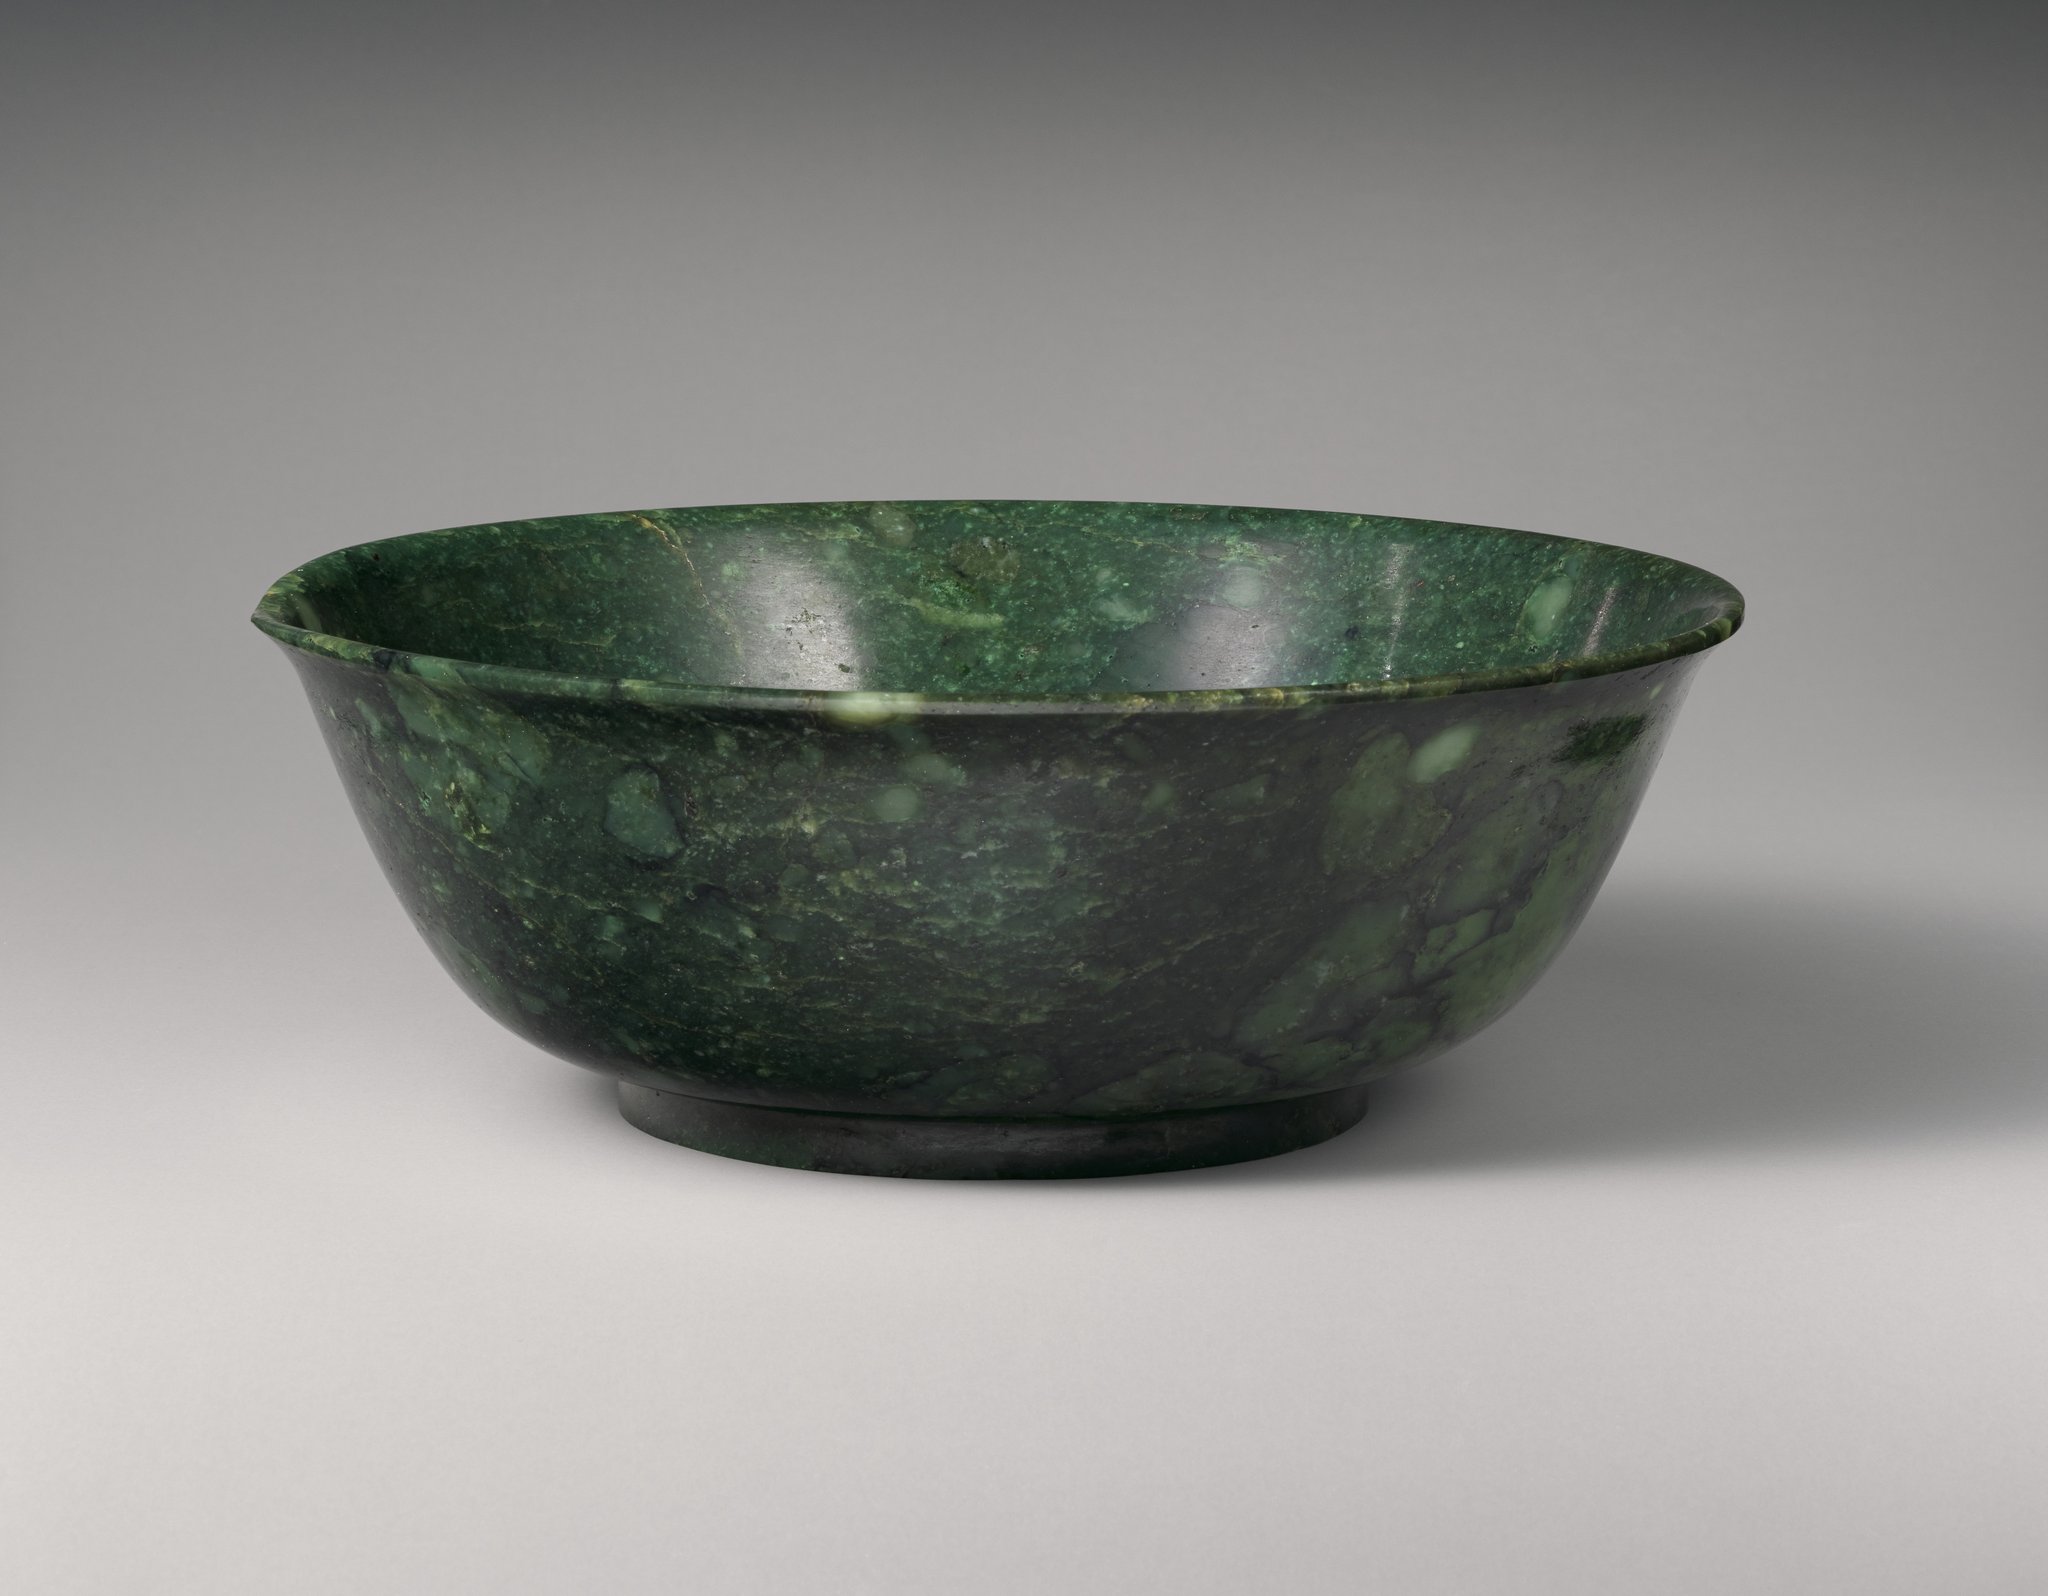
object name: bowl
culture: chinese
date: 1368-1644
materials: jade